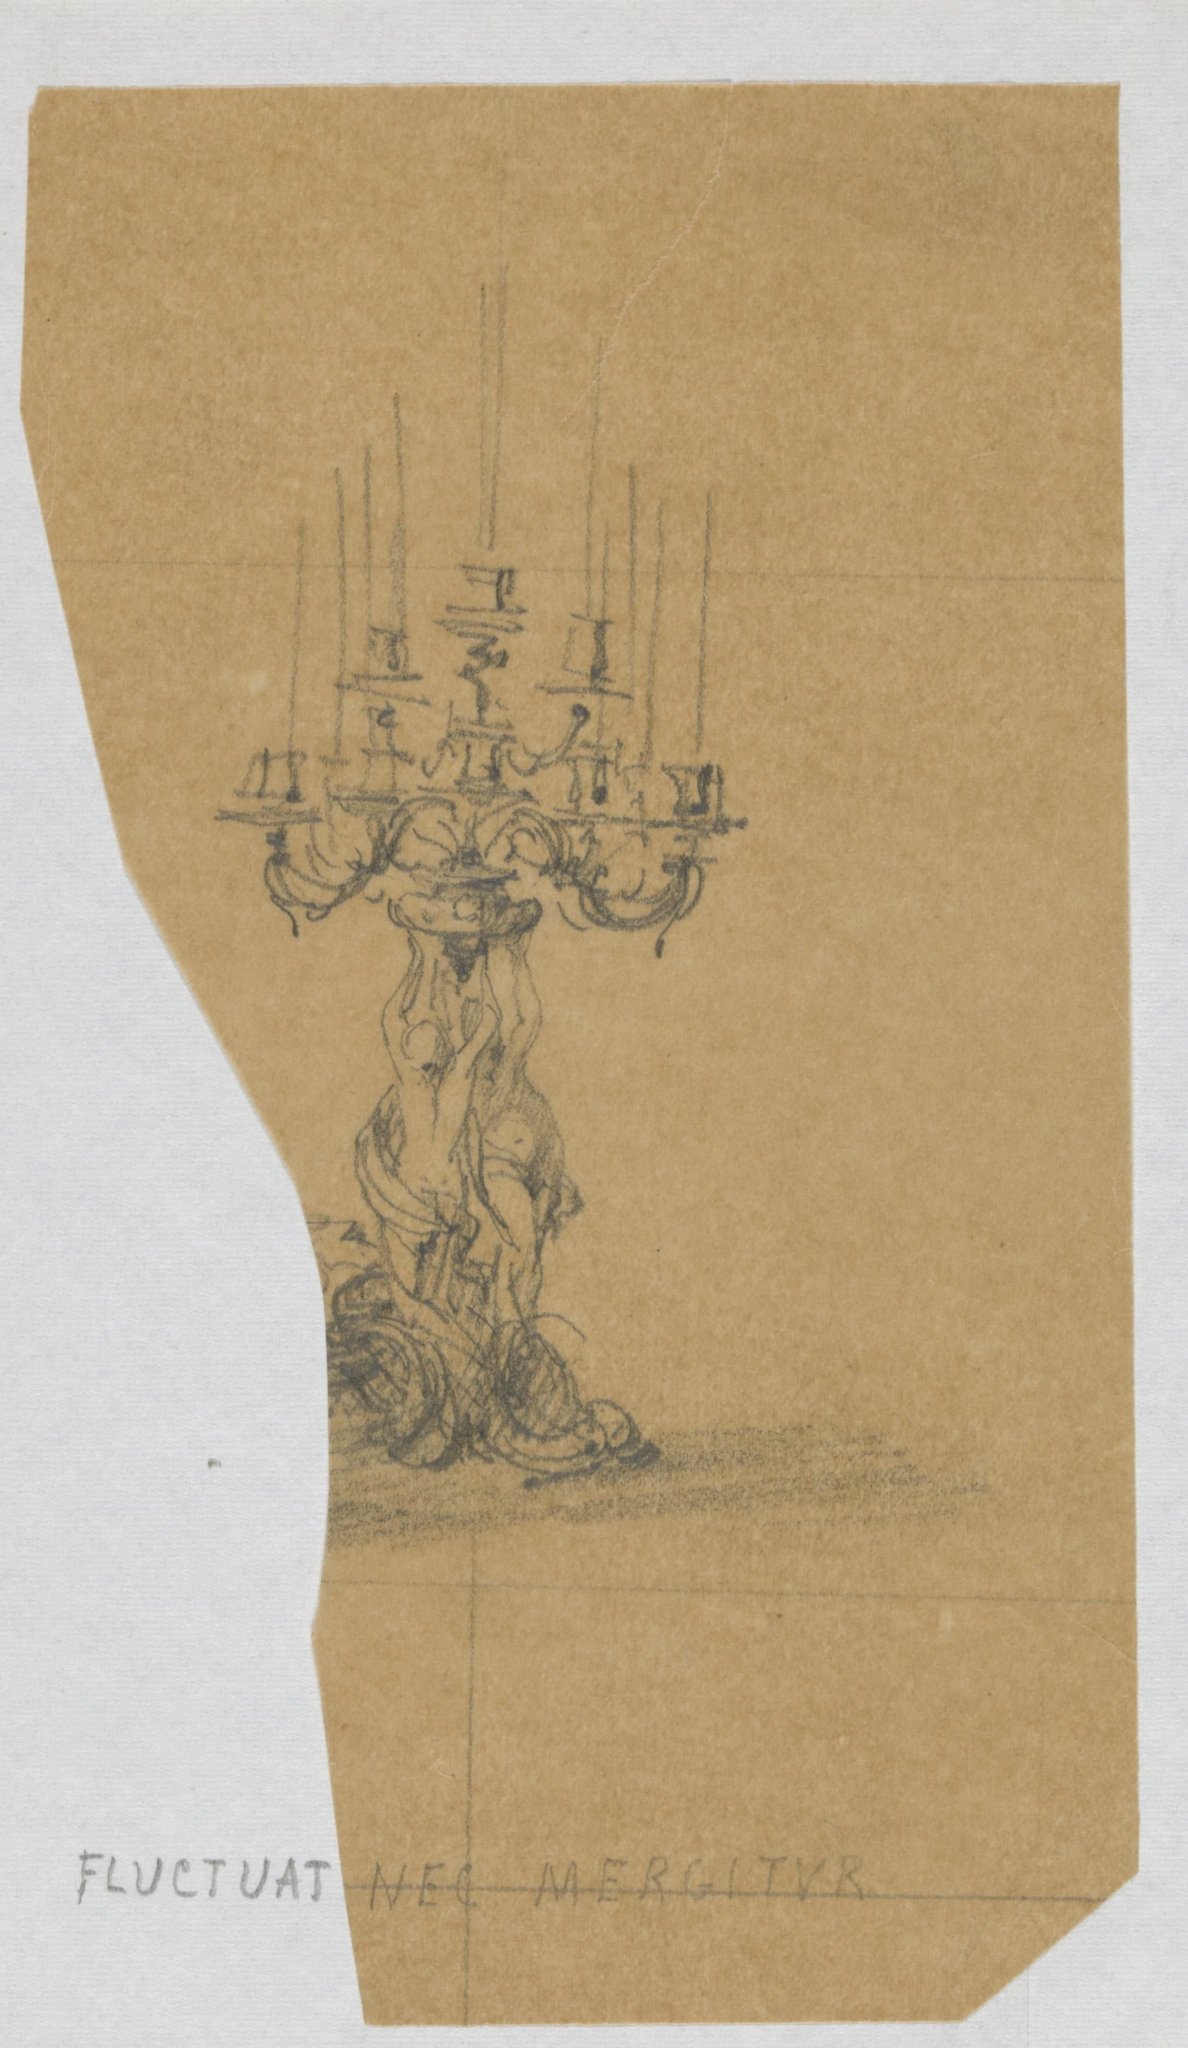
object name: design drawing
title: Ontwerp voor kandelaber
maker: henri cameré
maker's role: designer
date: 1864-1894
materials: pencil, paper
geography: paris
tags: chandelier, candelabrum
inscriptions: inscription: ‘FLUCTUAT NEC MERGITUR’